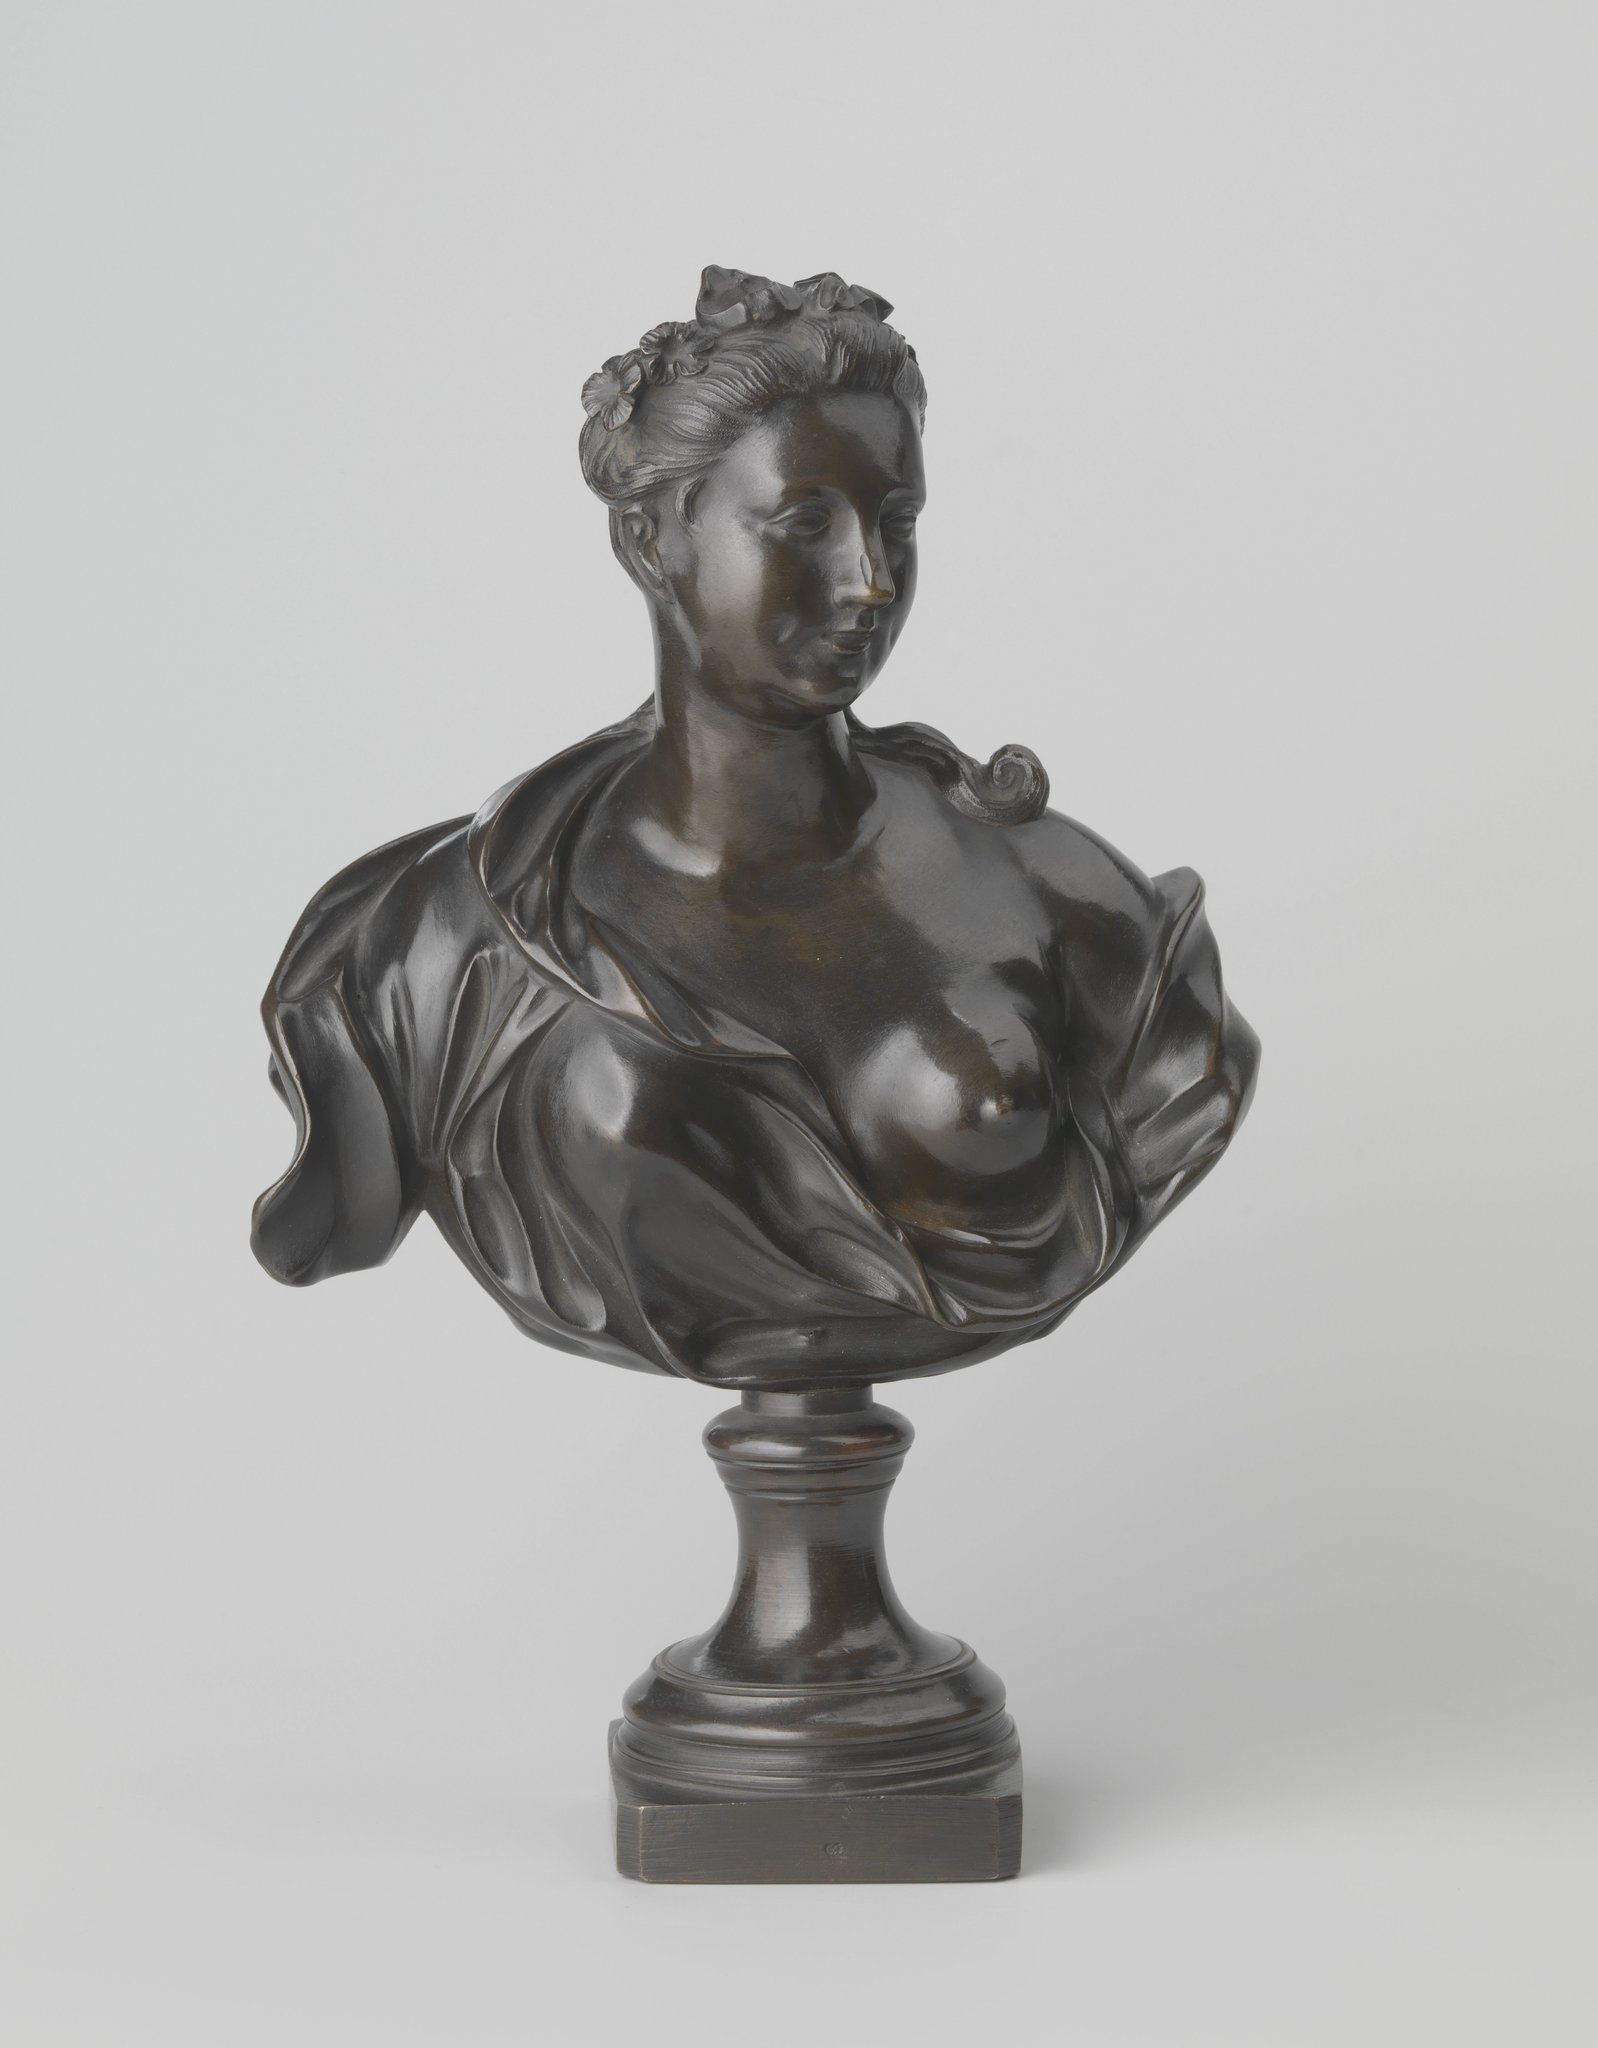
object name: sculpture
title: Flora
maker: Anonymous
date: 1745-1749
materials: bronze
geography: france